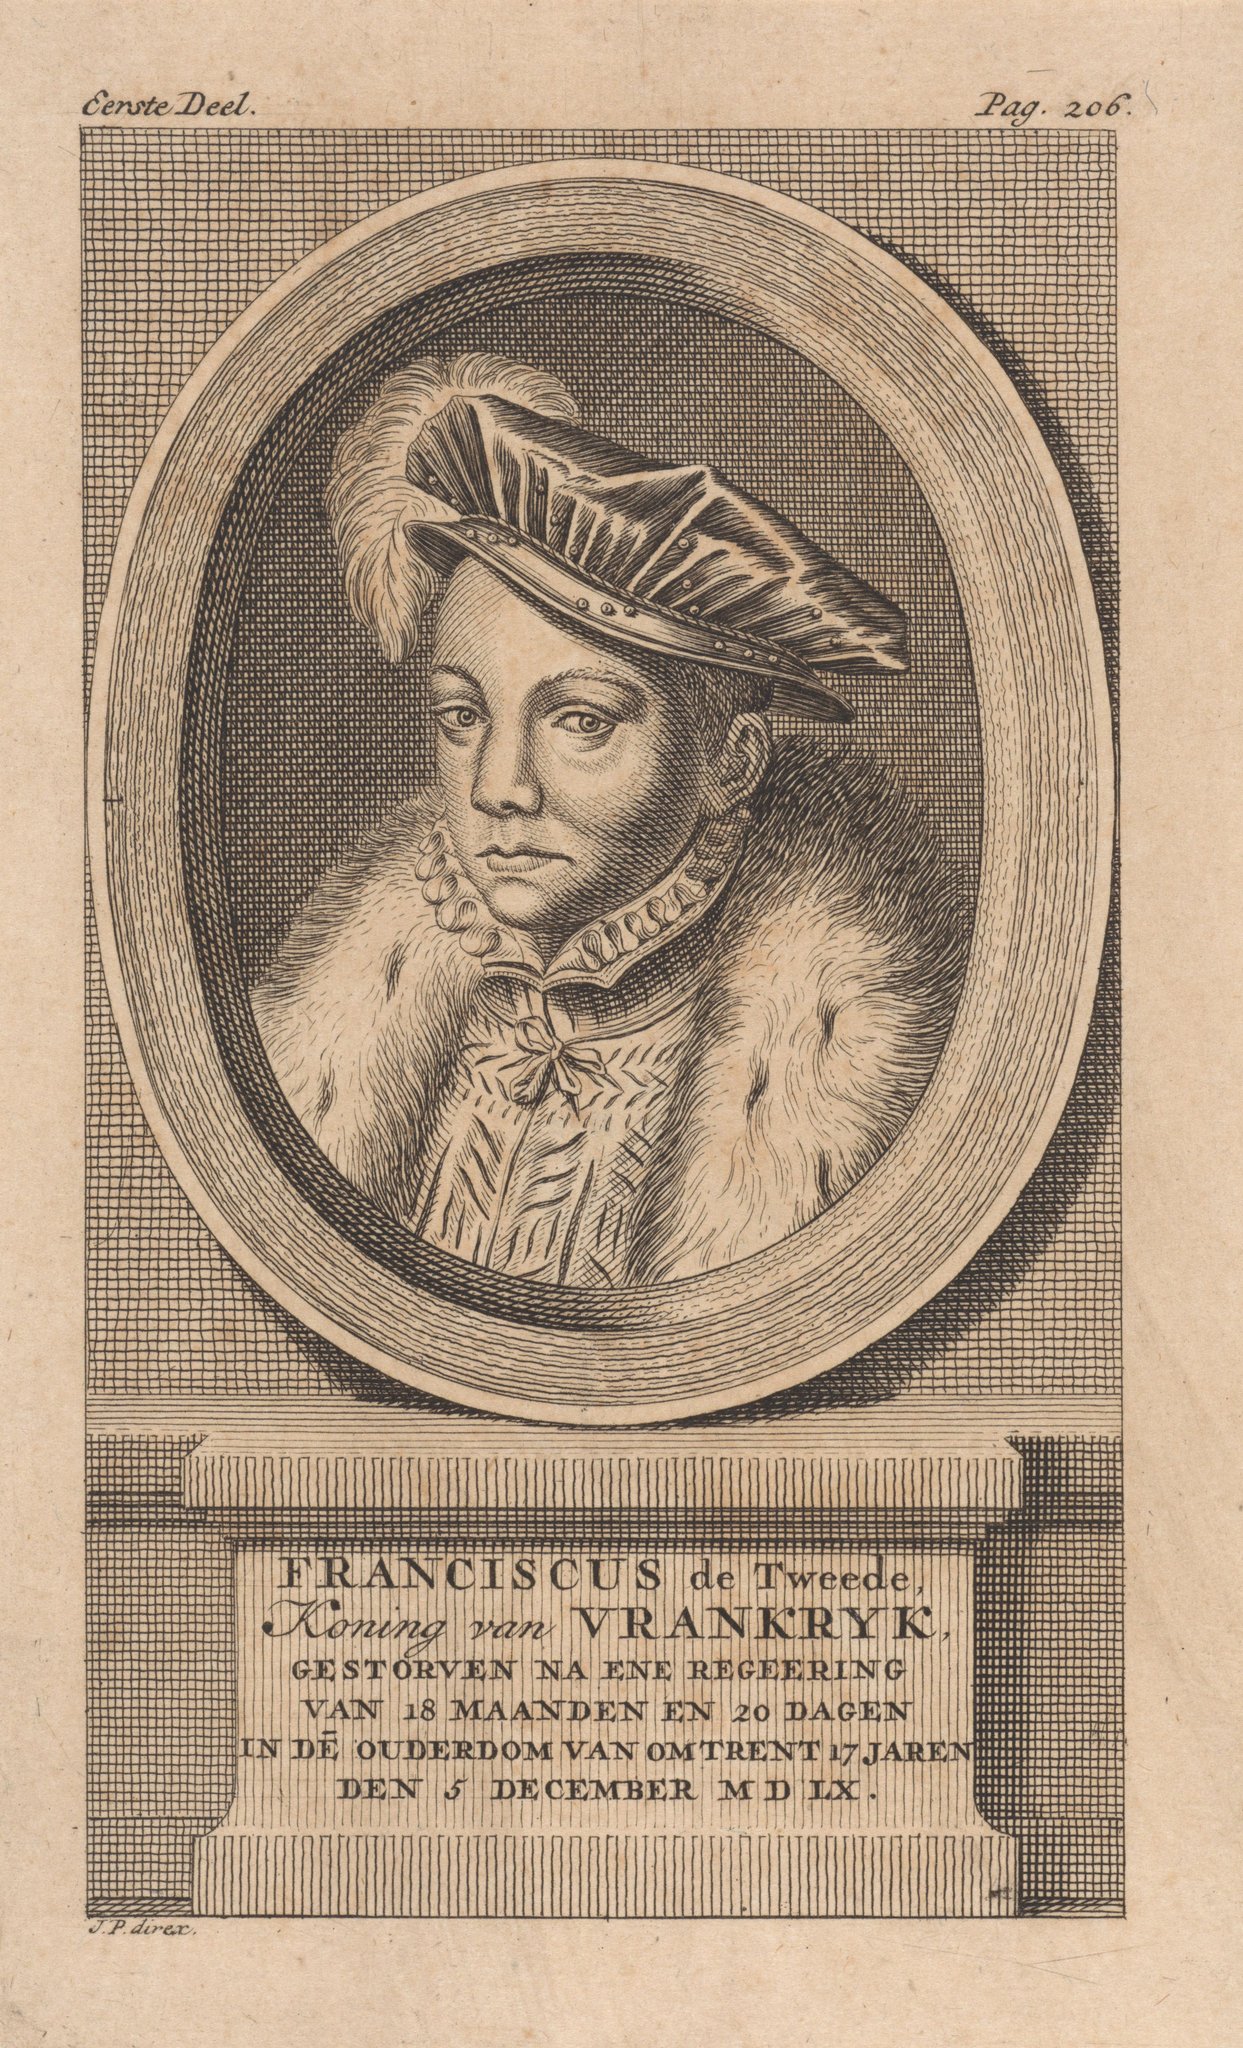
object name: print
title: Portret van Frans II, koning van Frankrijk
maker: jan punt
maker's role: draughtsman, print maker, publisher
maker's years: 1711-1779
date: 1748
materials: paper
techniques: engraving, etching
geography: northern netherlands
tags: paris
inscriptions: collector's mark: Lugt 2228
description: Prent gebruikt als illustratie in: Meteren, Emanuel van. Historie van de oorlogen en geschiedenissen der Nederlanderen, en der zelver naburen: beginnende met den jare 1315, en eindigende met den jare 1611, deel I, p. 206. Gorinchem/Breda: Nicolaas Goetzee, Pieter Goetzee/Willem Goetzee, 1748.